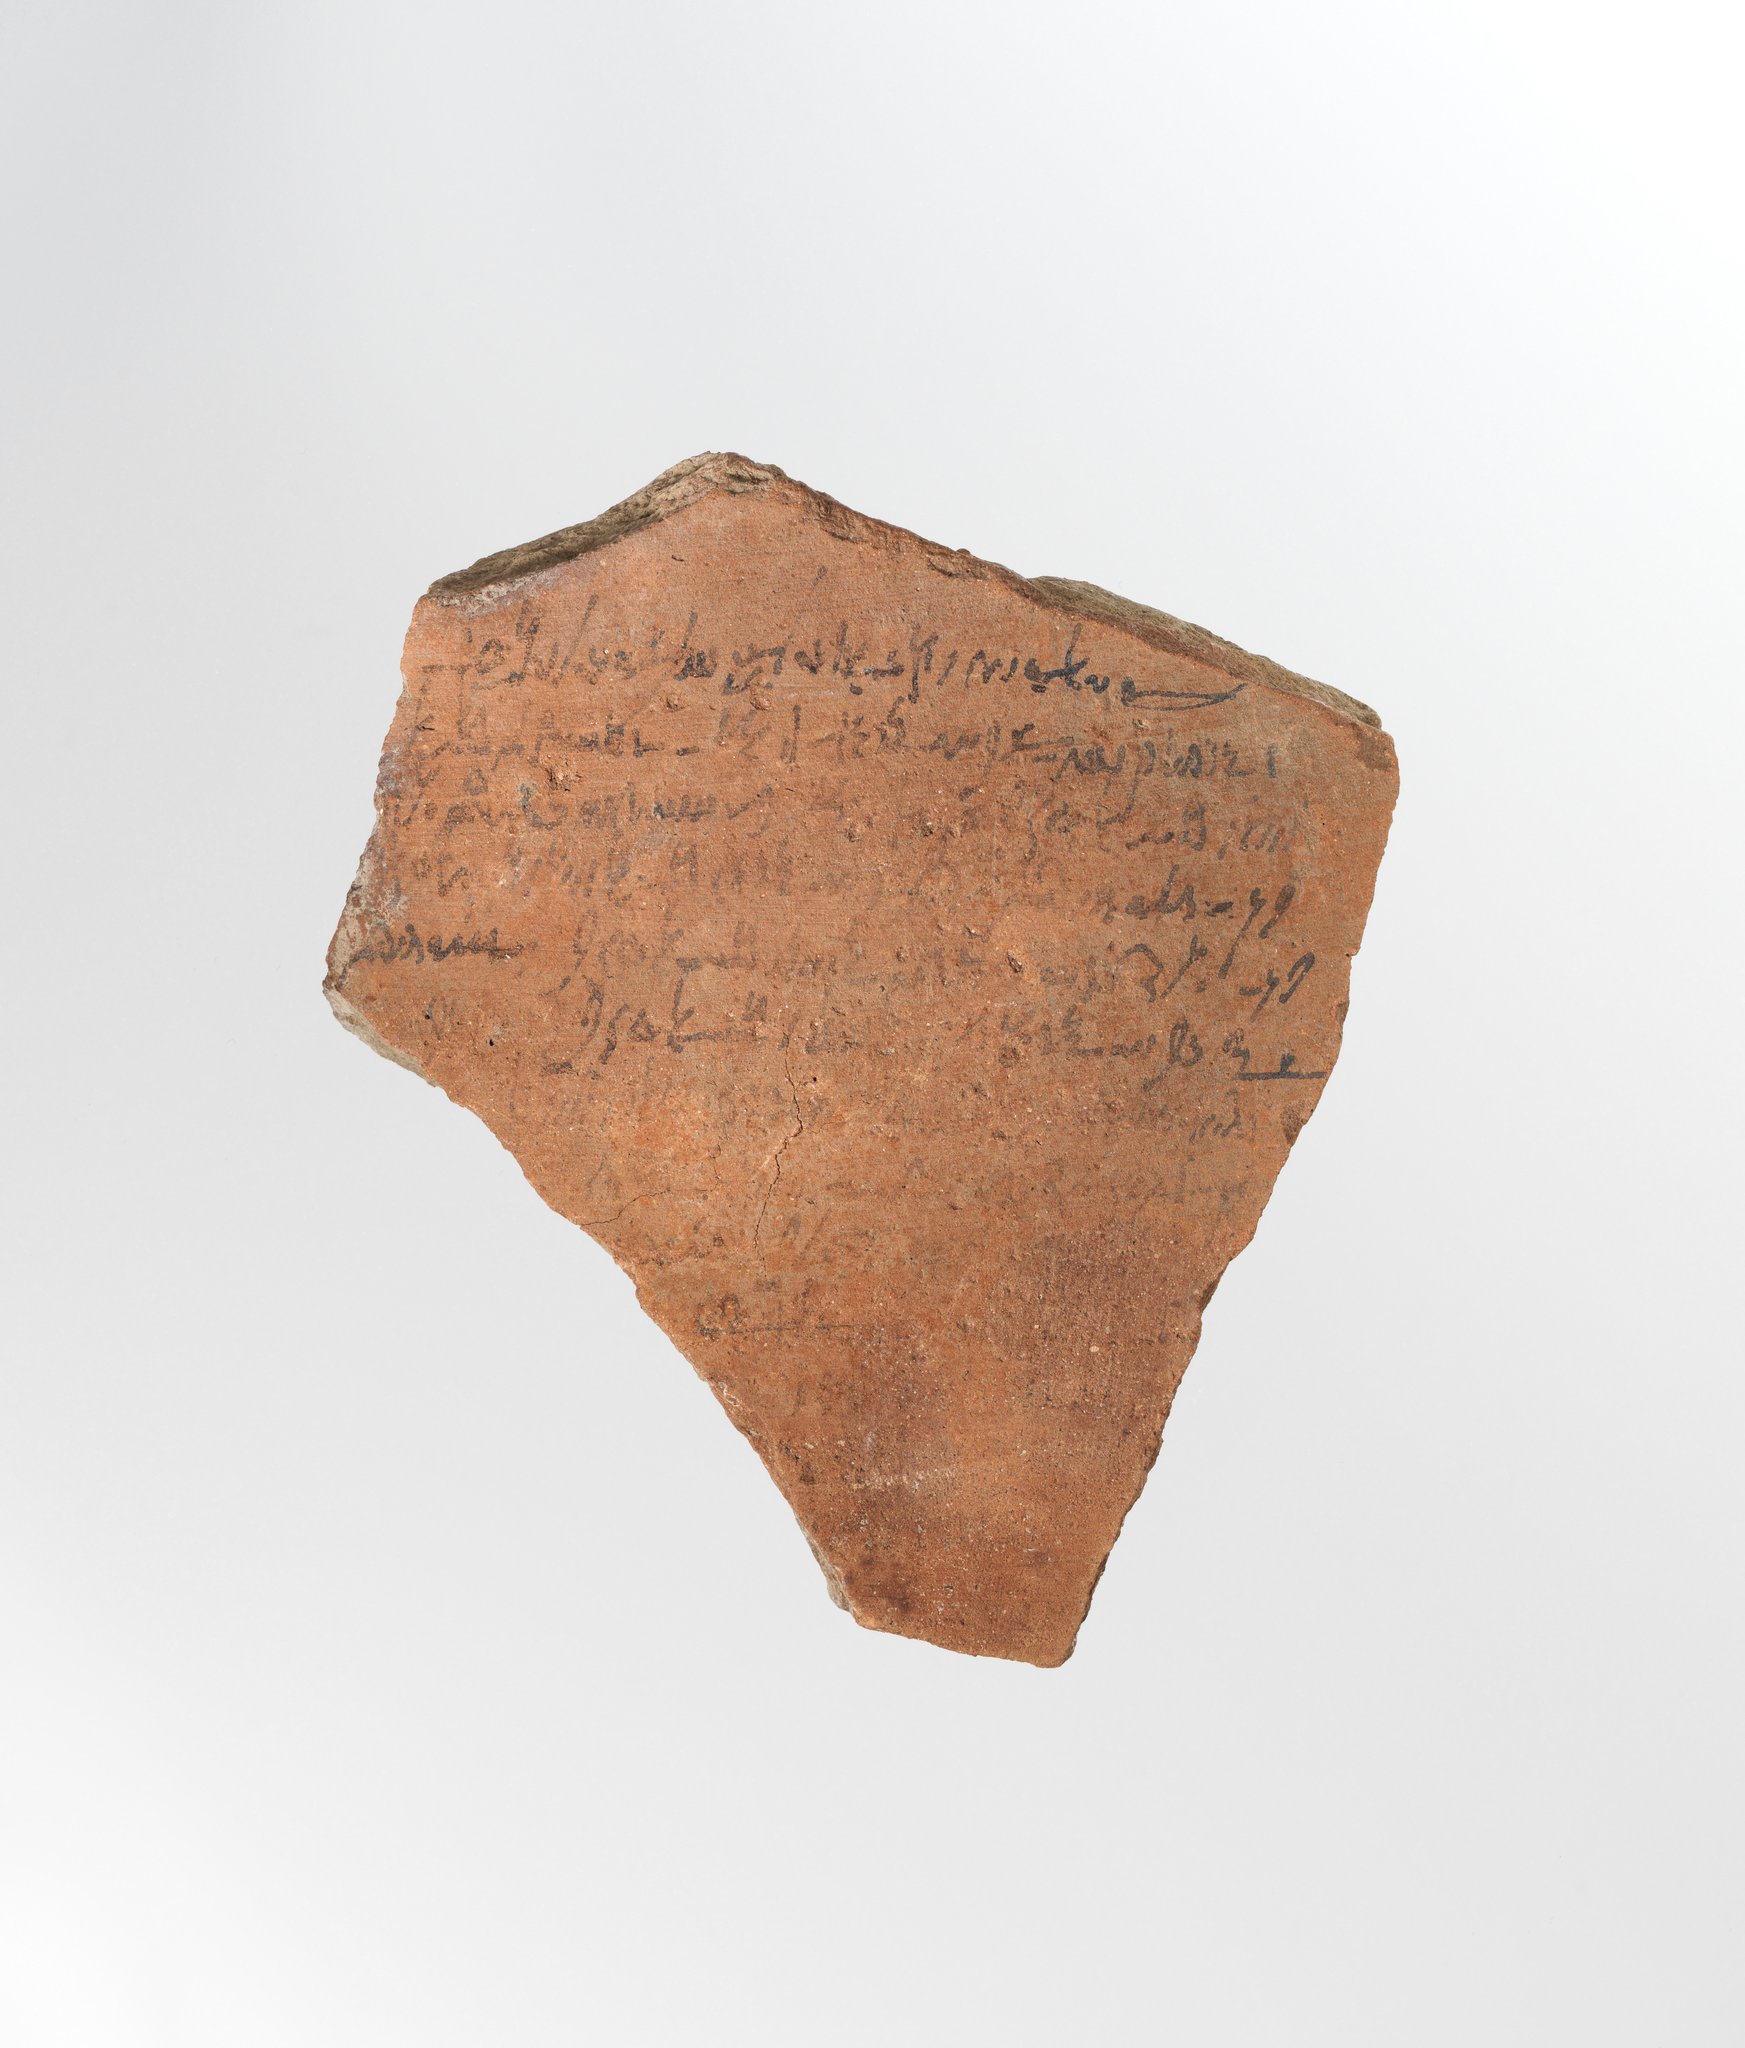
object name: ostracon, tax receipt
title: Ostracon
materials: ink, pottery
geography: egypt